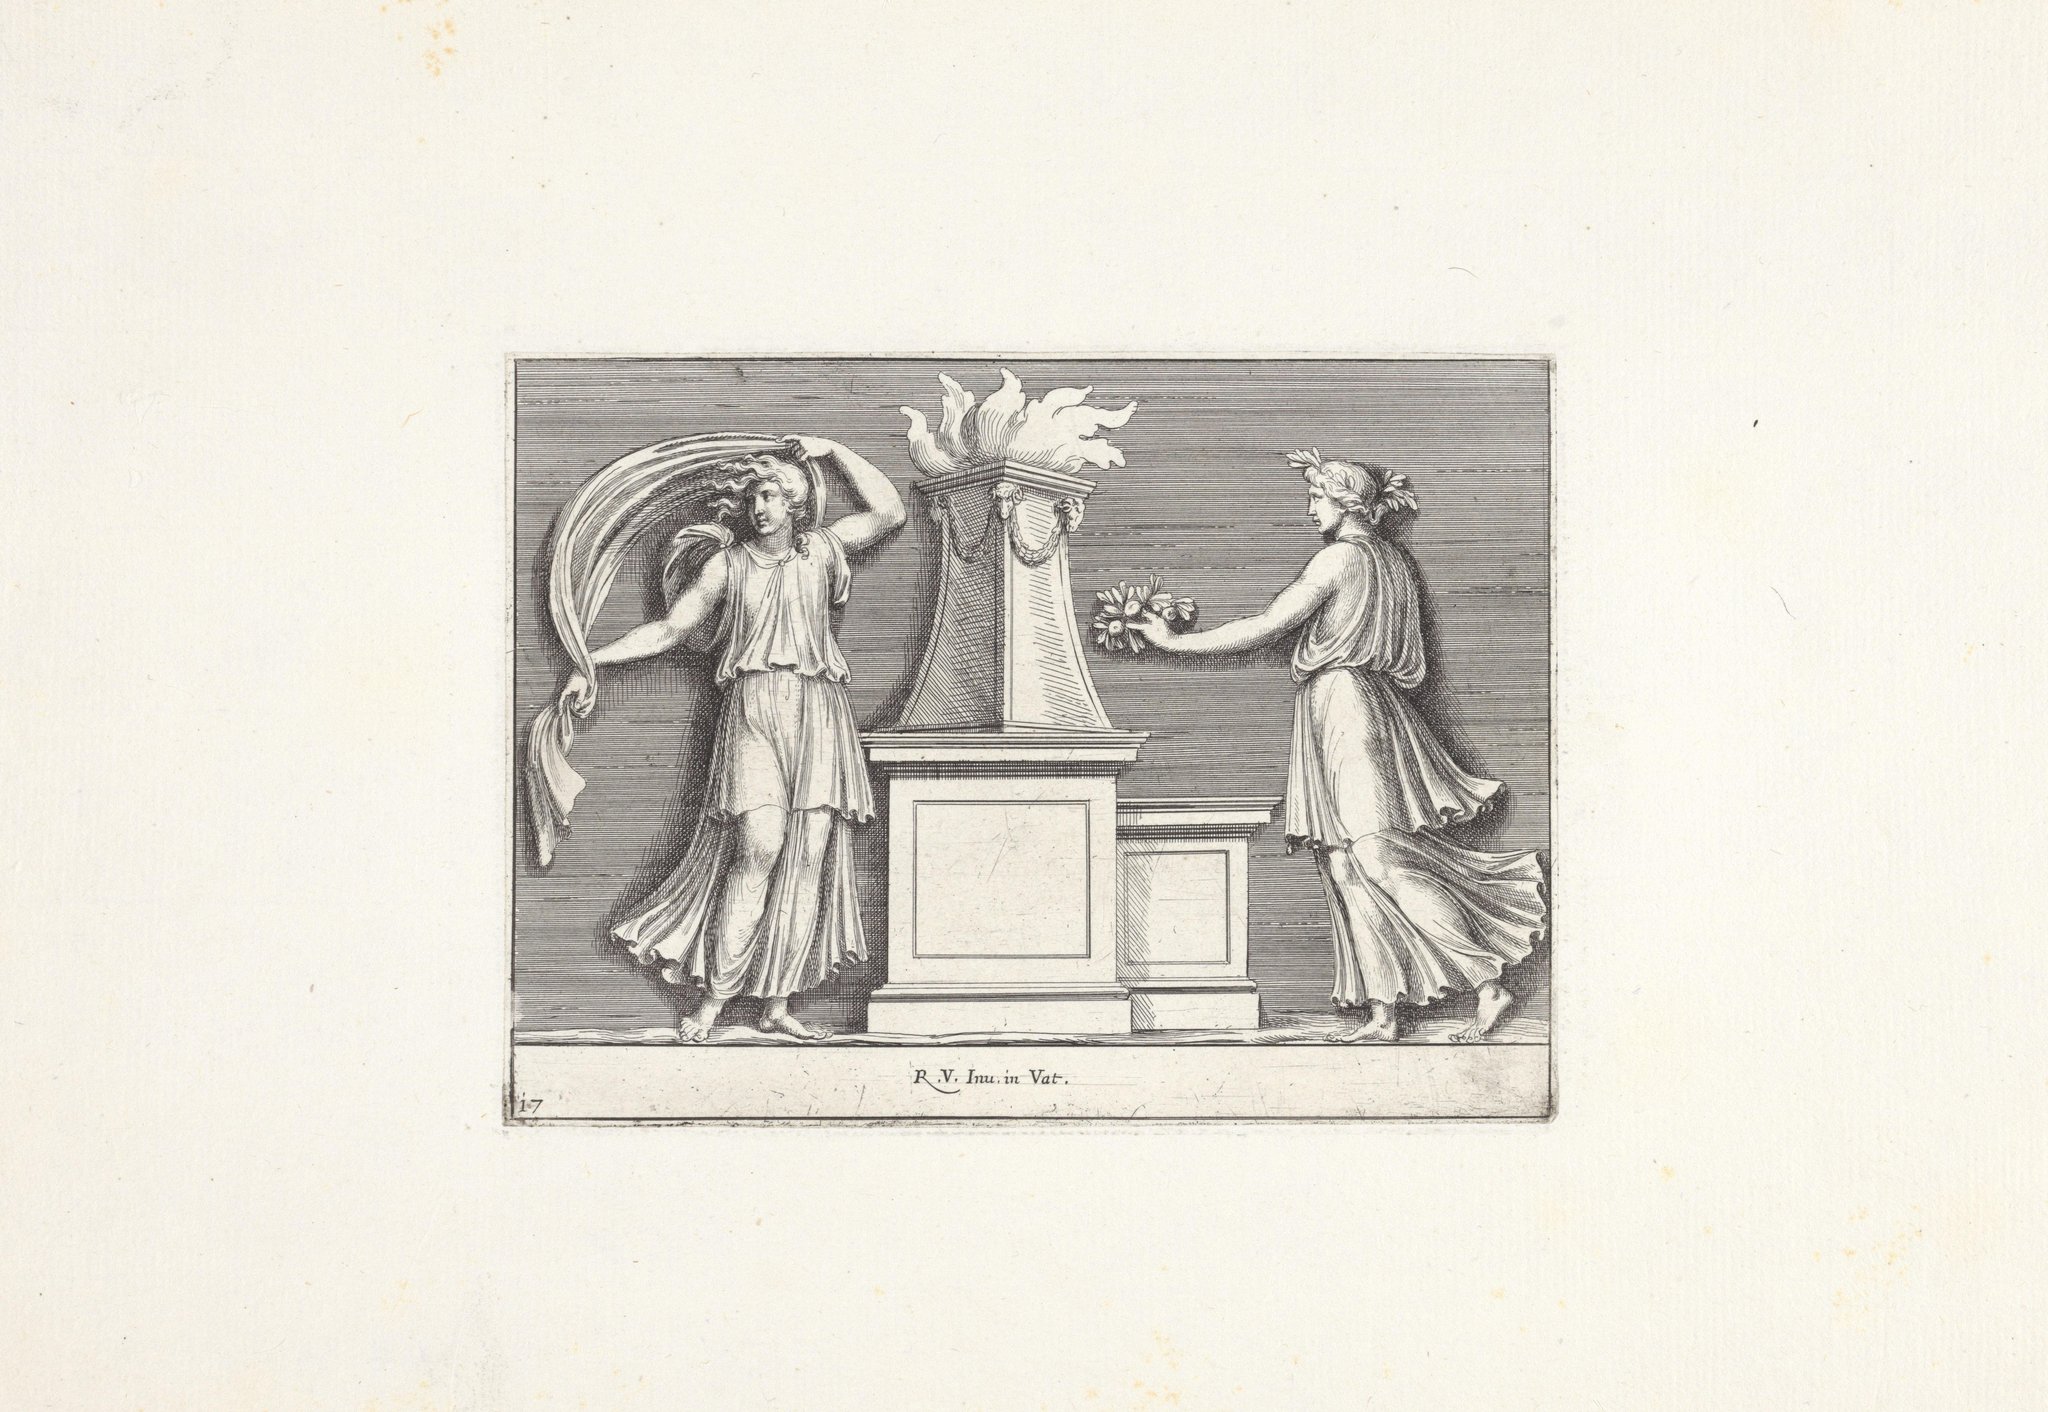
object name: print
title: Reliëfs in de Loggia van Rafaël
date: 1645-1700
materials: paper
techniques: engraving, etching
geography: vatican city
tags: adult woman, sacrifice ~ roman religion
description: Prent uit een reeks naar de gipsen reliëfs door Rafaël en uitgevoerd door zijn assistenten in de Vaticaanse Loggia.